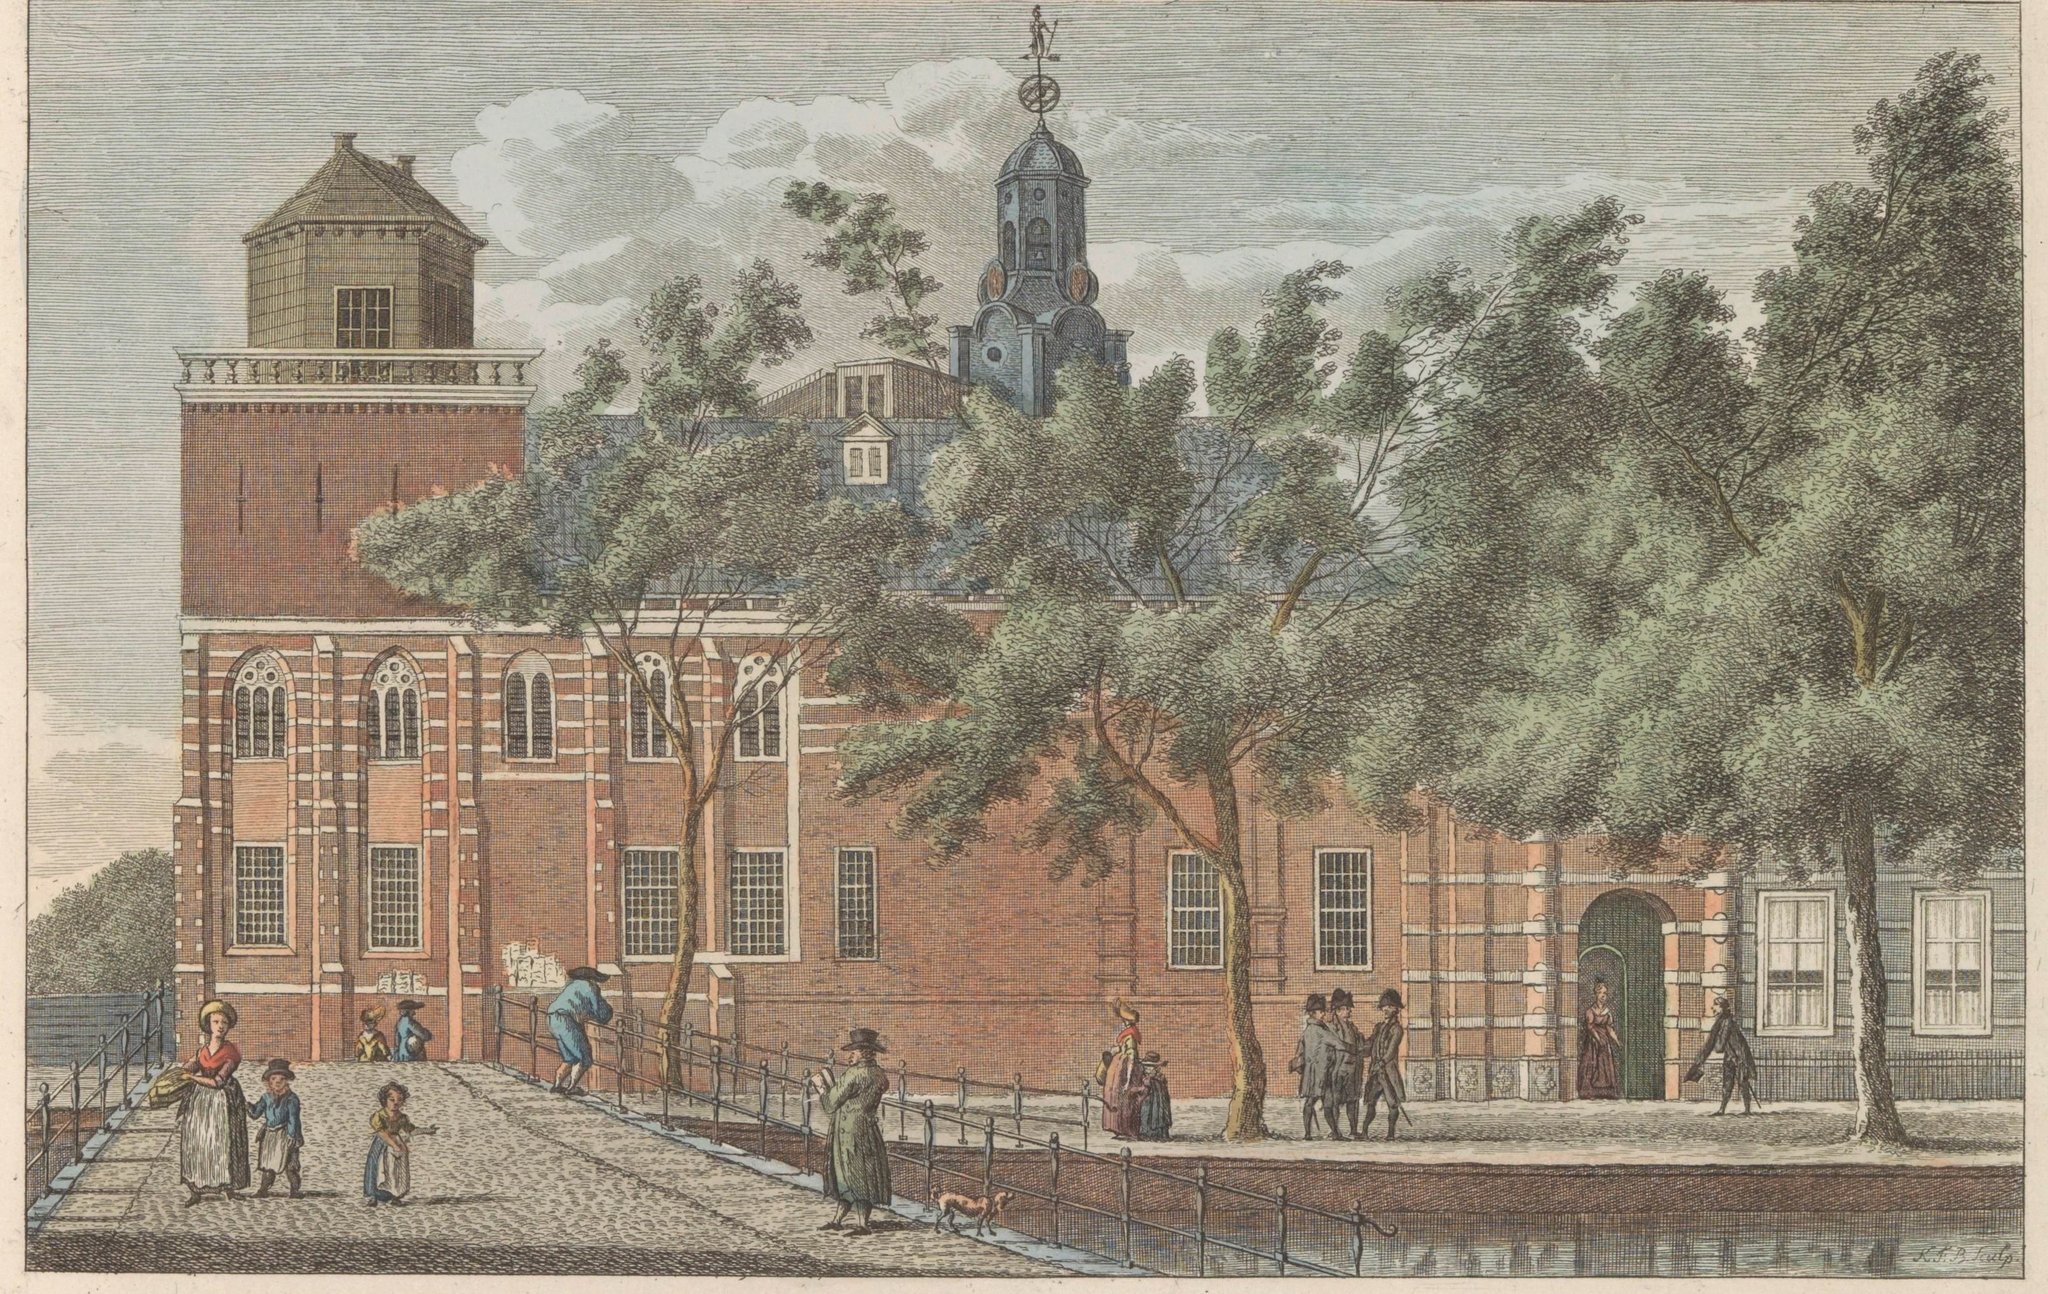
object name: print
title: De Akademie te Leiden / Vue de L'academie à Laiden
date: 1786-1792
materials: paper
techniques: engraving, etching, hand coloring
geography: amsterdam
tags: leiden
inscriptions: inscription: ‘Vue de L'academie à Laiden/ chez E: Maaskamp à Amsterdam’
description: Huidige staat van prent uitgegeven als onderdeel van een plaatwerk uit ca. 1824-1825 met 74 (ongenummerde) platen van de belangrijkste topografische gezichten en verschillende zeden en gewoonten in het Verenigd Koninkrijk der Nederlanden, getiteld 'Tableau des principales vues des palais et édifices : représentations et des coutumes et usages, dans les provinces septentrionales du Royaume des Pays-Bas'. Eerdere staat gebruikt in: Vaderlandsche gezichten, of afbeeldingen van den tegenwoordigen staat der Vereenigde Nederlanden (…). Amsterdam: Hendrik Gartman, Willem Vermandel en Jan Willem Smit, 1786-1792. Uitgegeven in afleveringen met ieder een eigen bifolium en inhoudsopgave. Alle prenten in deze publicatie zijn gegraveerd door Carel Frederik Bendorp (I) en, in de meeste gevallen, gebaseerd op tekeningen van Jan Bulthuis.